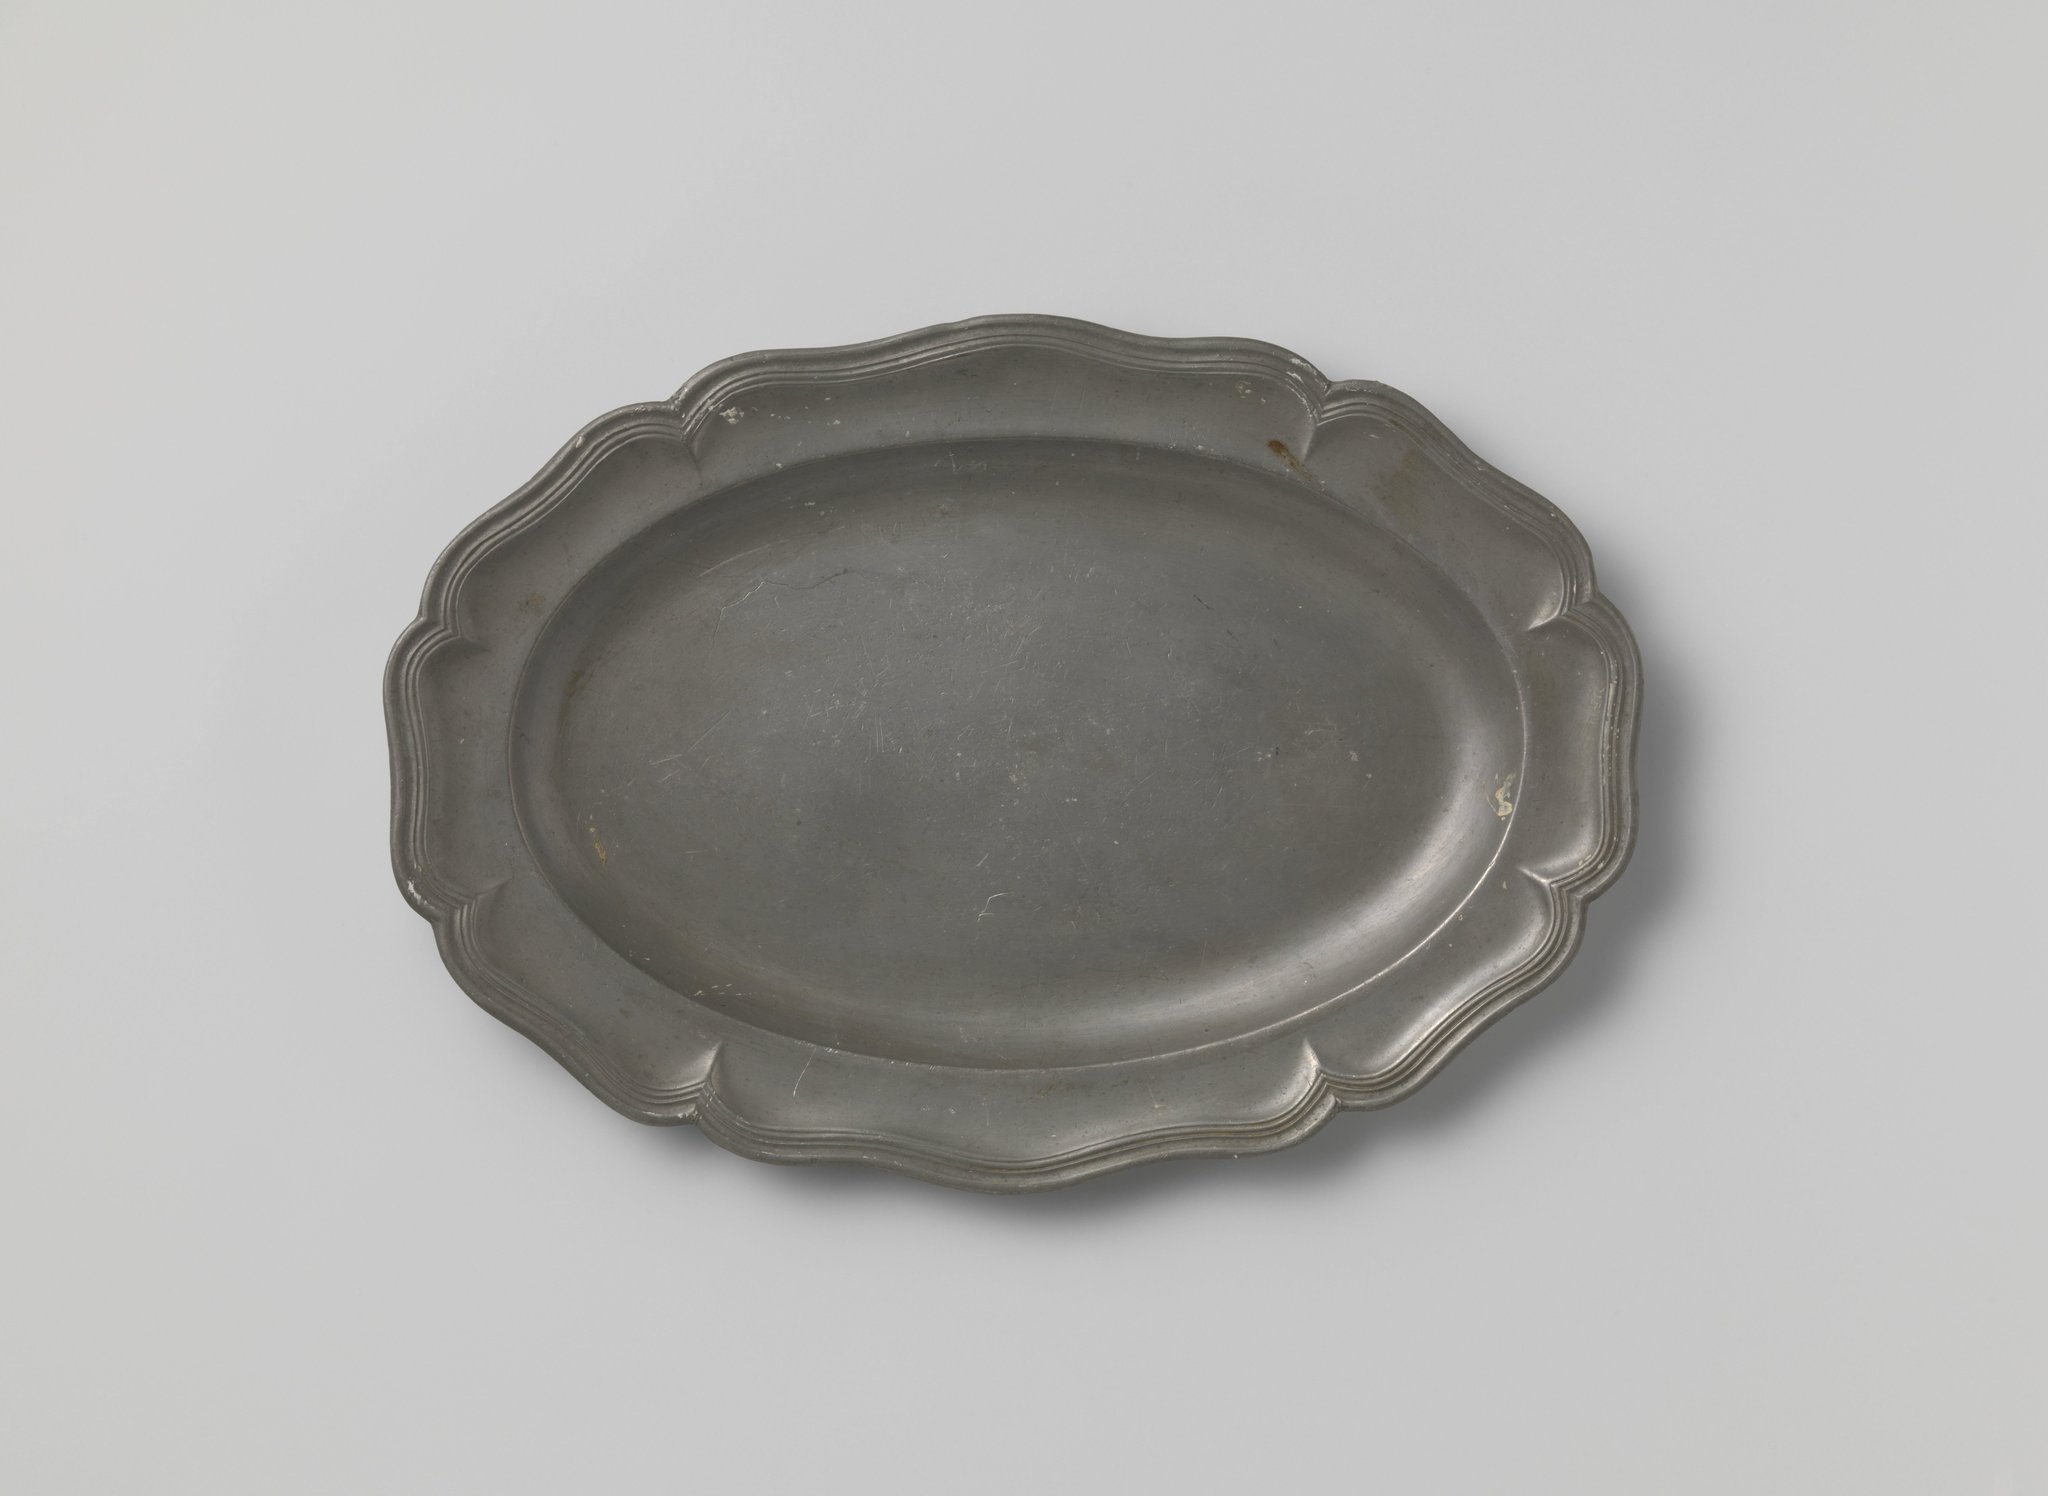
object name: platter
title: Ovale schotel met geschulpte rand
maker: carolus theodorus de ruijr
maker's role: pewterers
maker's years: 1749-1795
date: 1770-1795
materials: tin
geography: roermond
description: Ovale schotel van tin. De rand is geschulpt en geprofileerd.